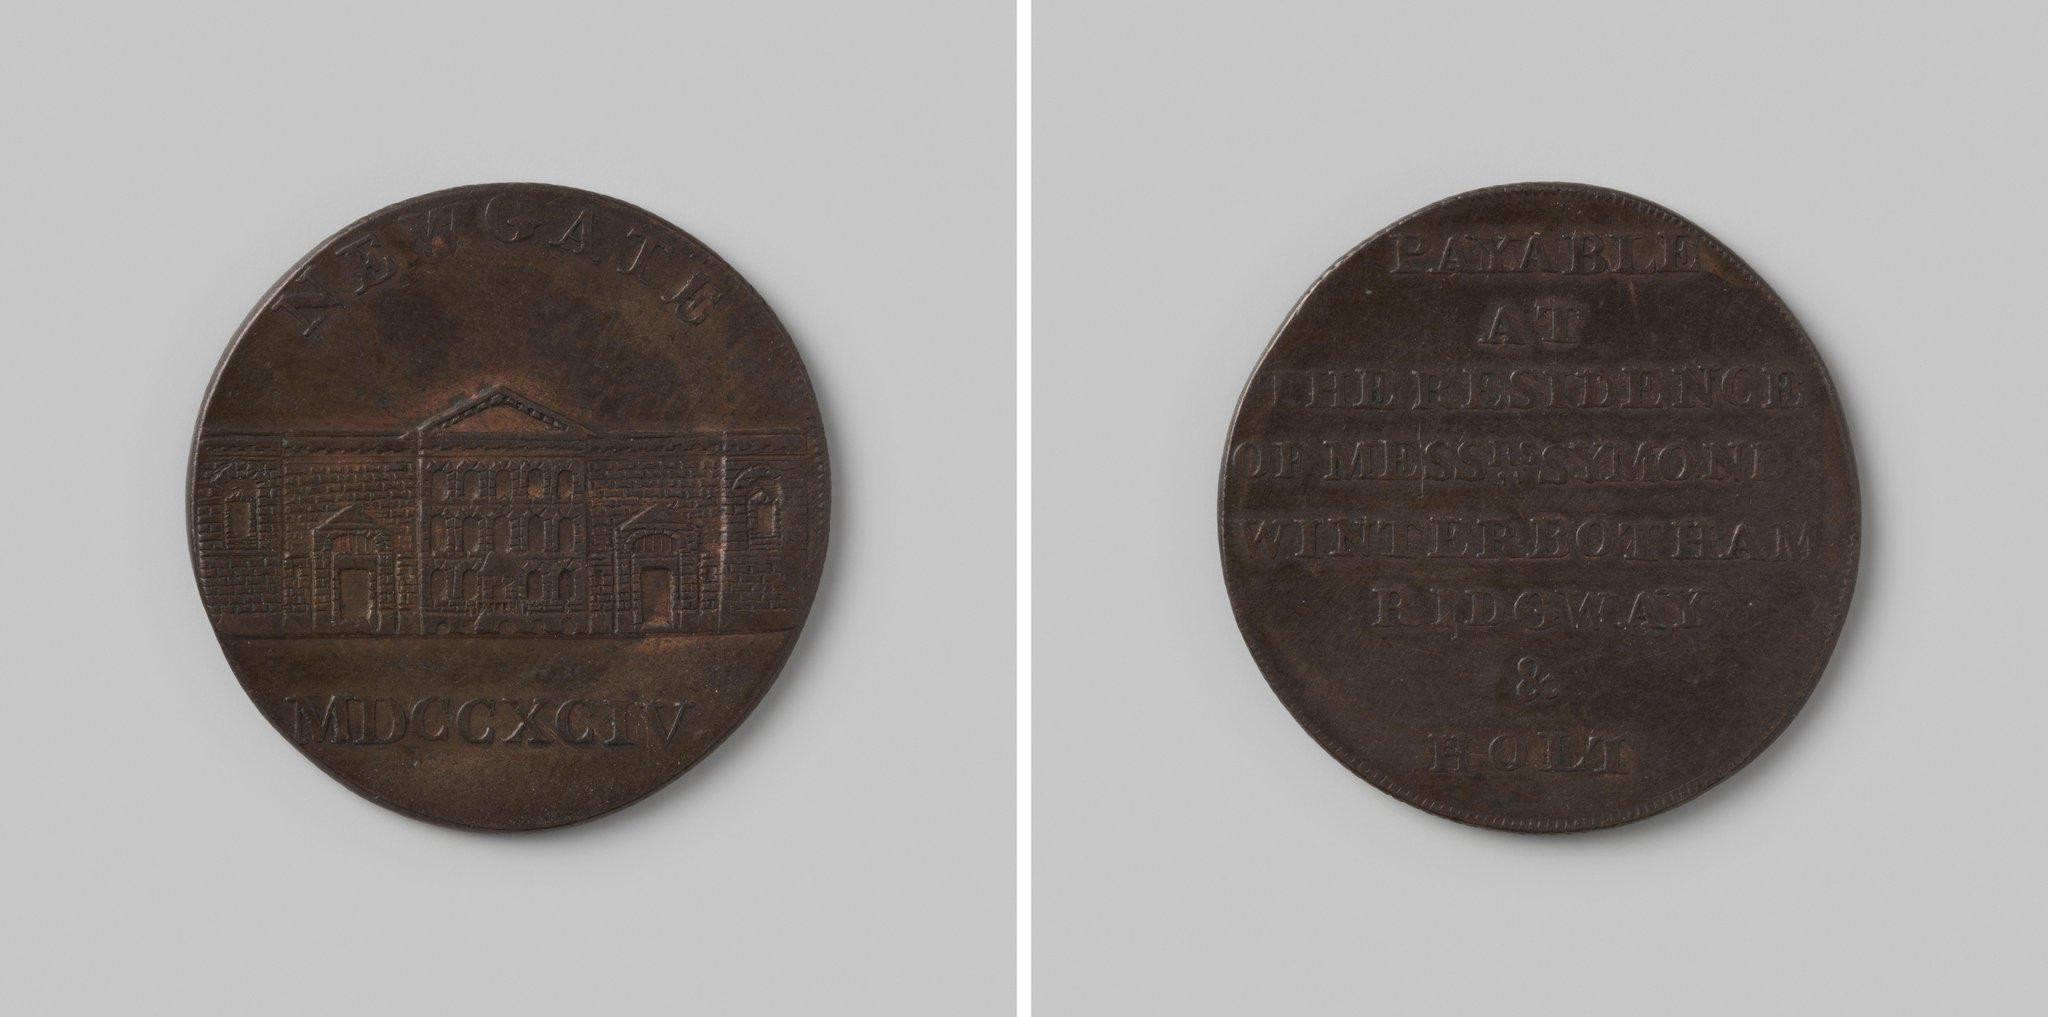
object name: history medal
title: Token van Symond, Winterbotham, Ridgway & Holt te Newgate 1794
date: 1794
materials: copper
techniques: striking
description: Koperen penning, op de voorzijde het aanzicht van de gevangenis van Newgate met omschrift en afsnedetekst, op de keerzijde acht regels tekst.